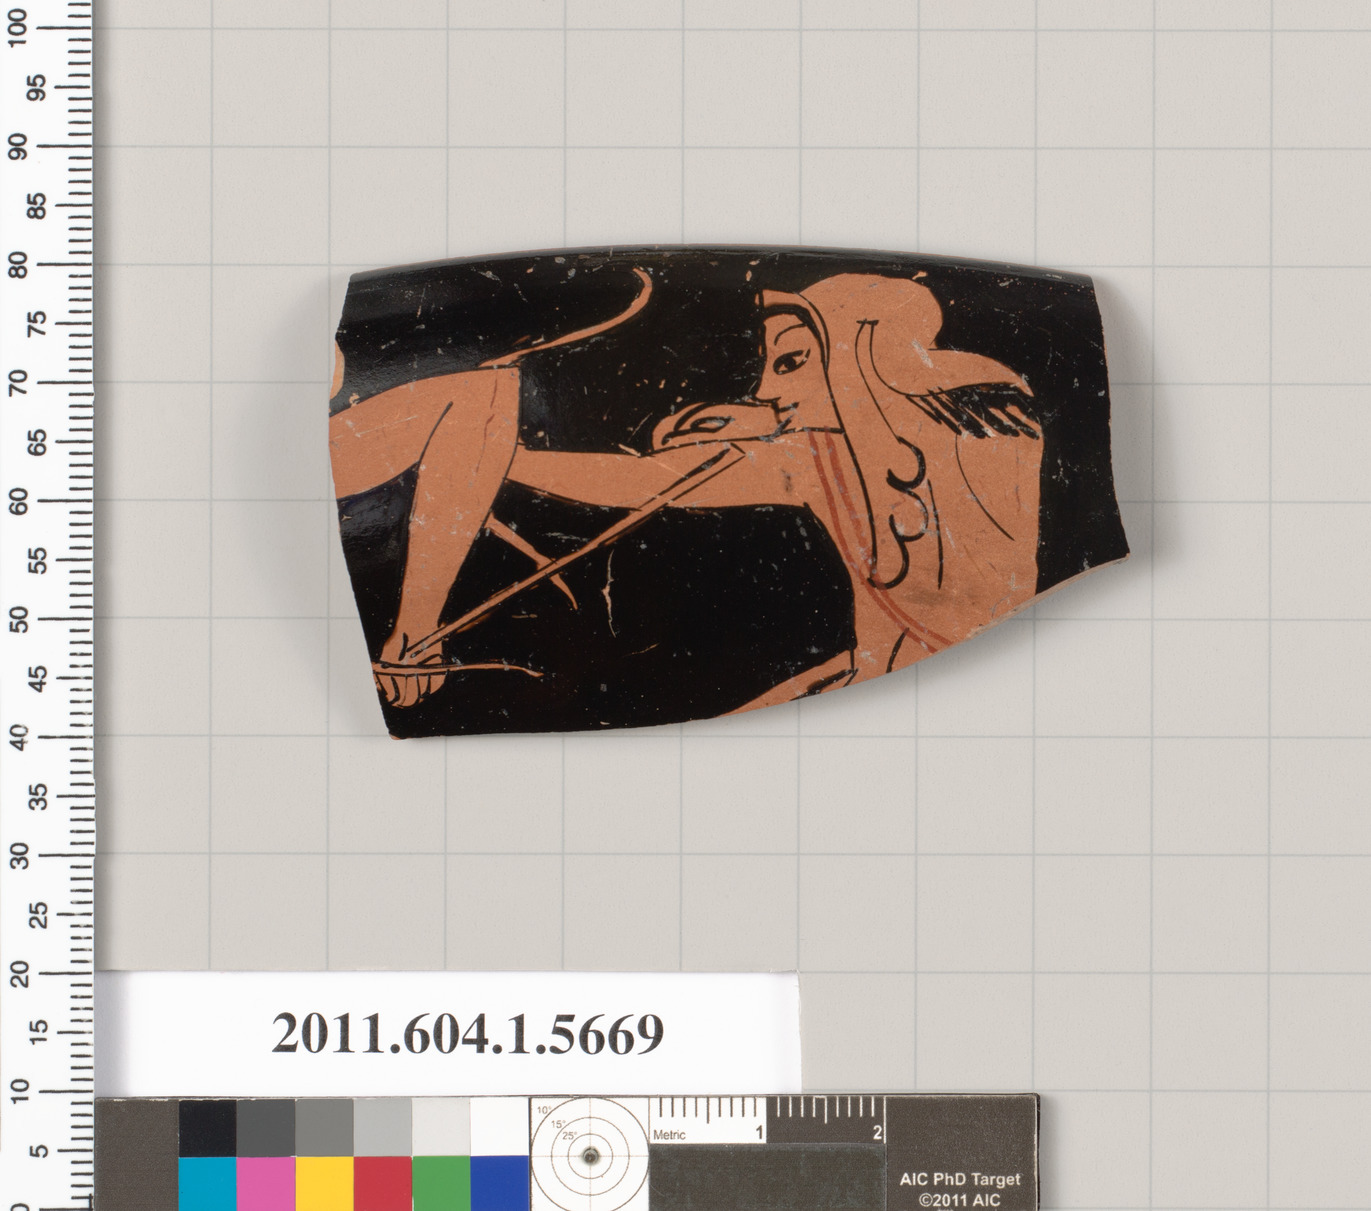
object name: kylix fragment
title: Terracotta rim fragment of a kylix (drinking cup)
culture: greek, attic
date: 500-480 BCE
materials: terracotta